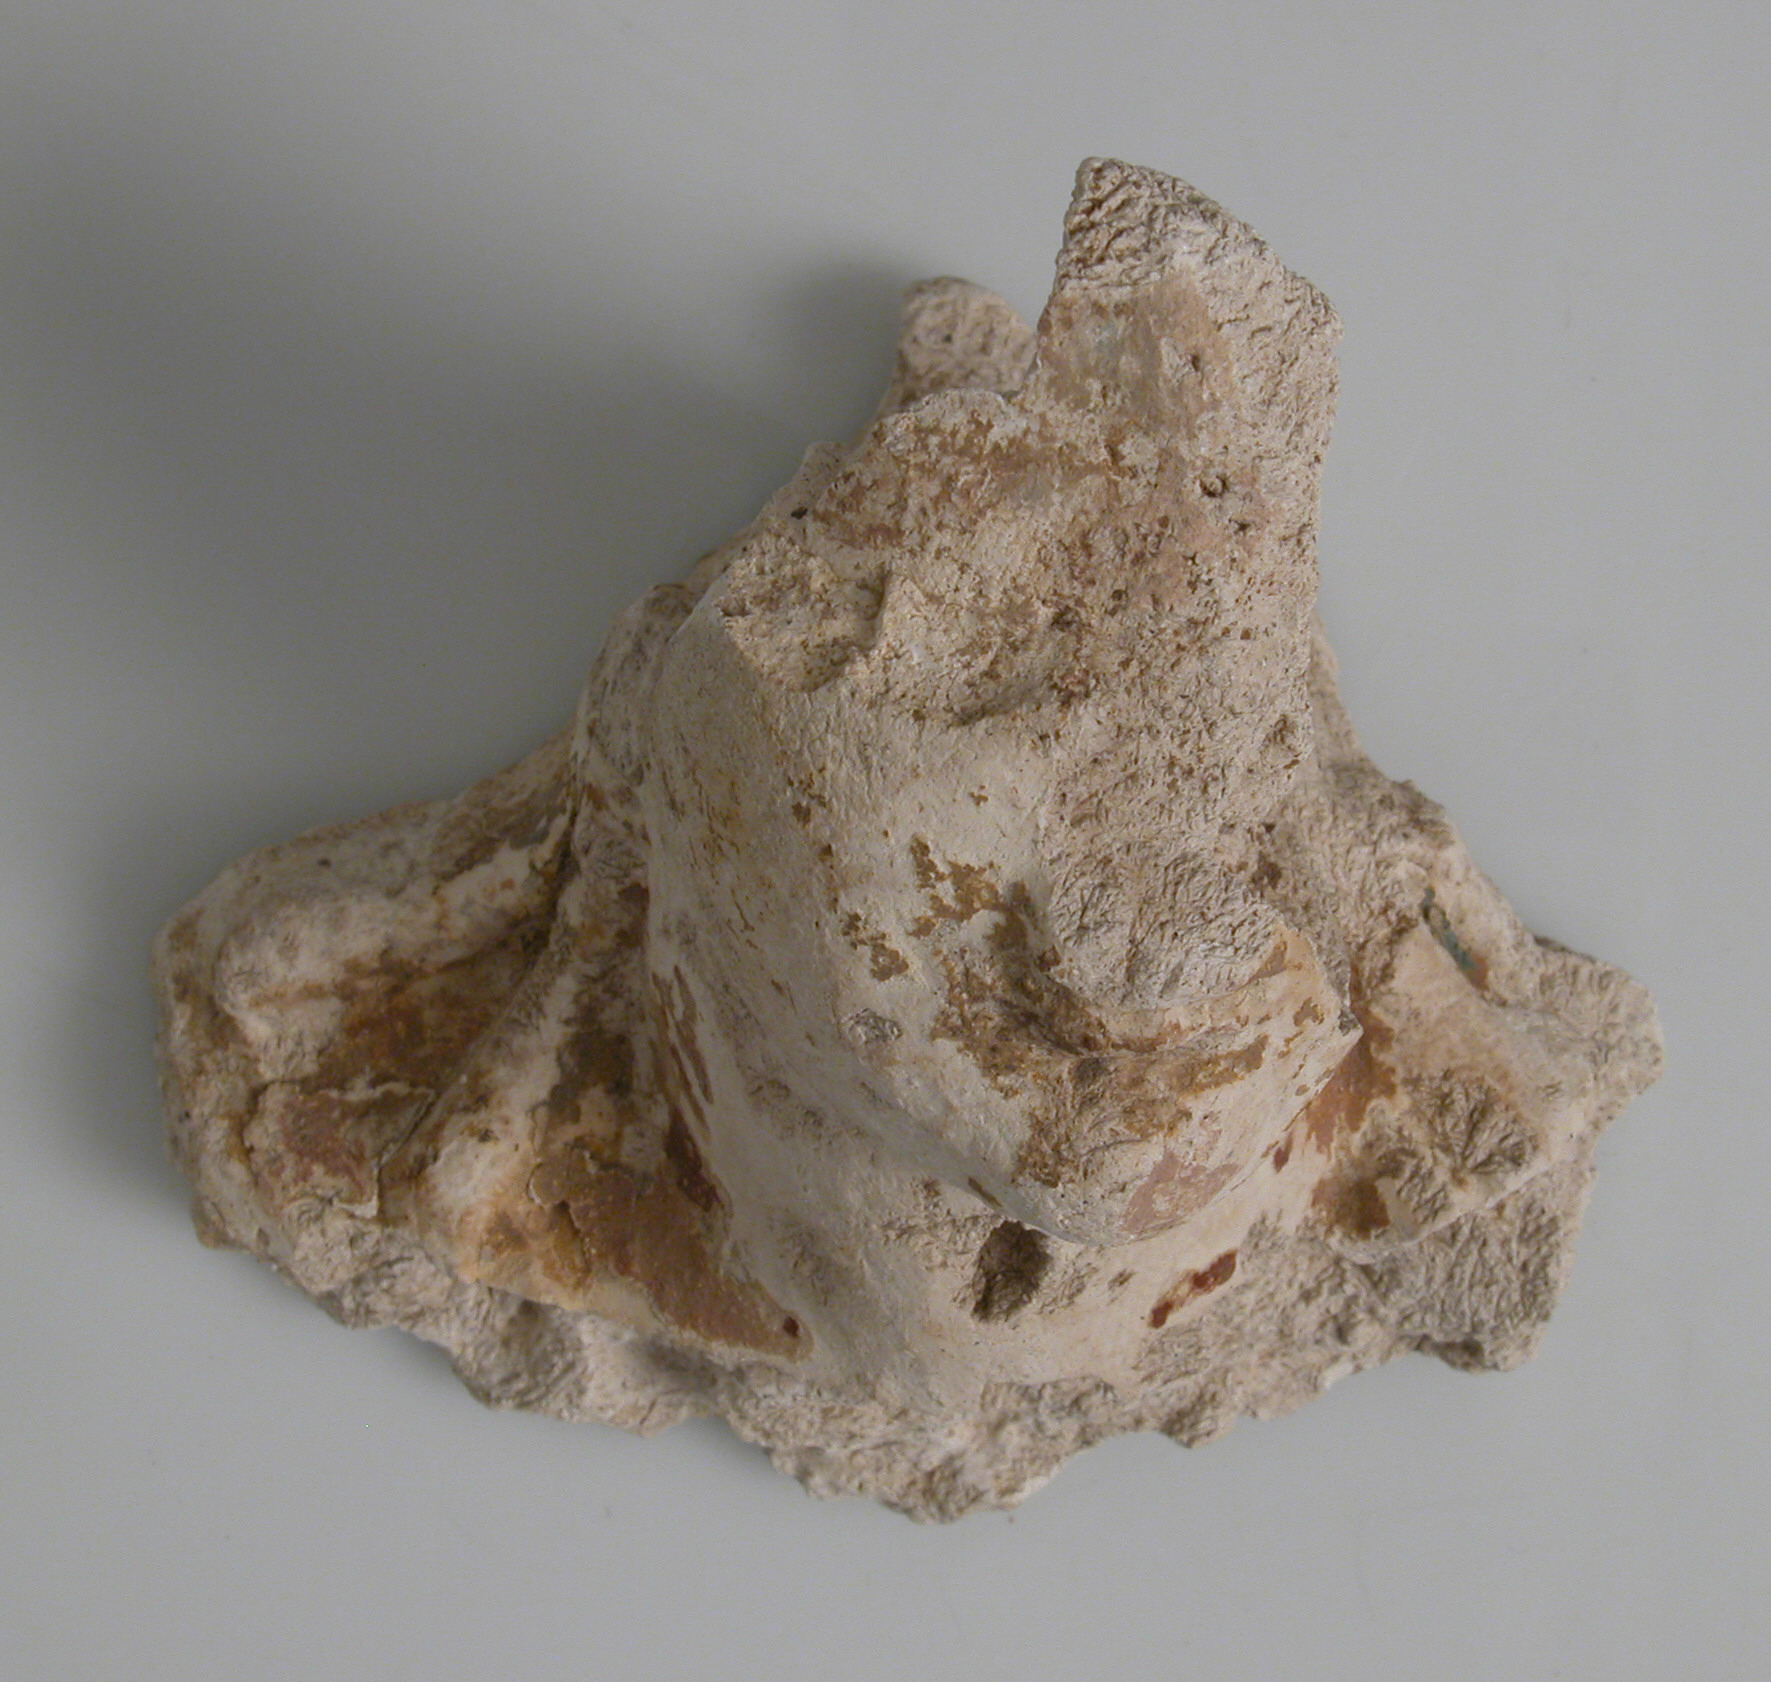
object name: statuette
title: Head and Neck Fragment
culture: coptic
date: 301-700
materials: plaster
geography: egypt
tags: heads